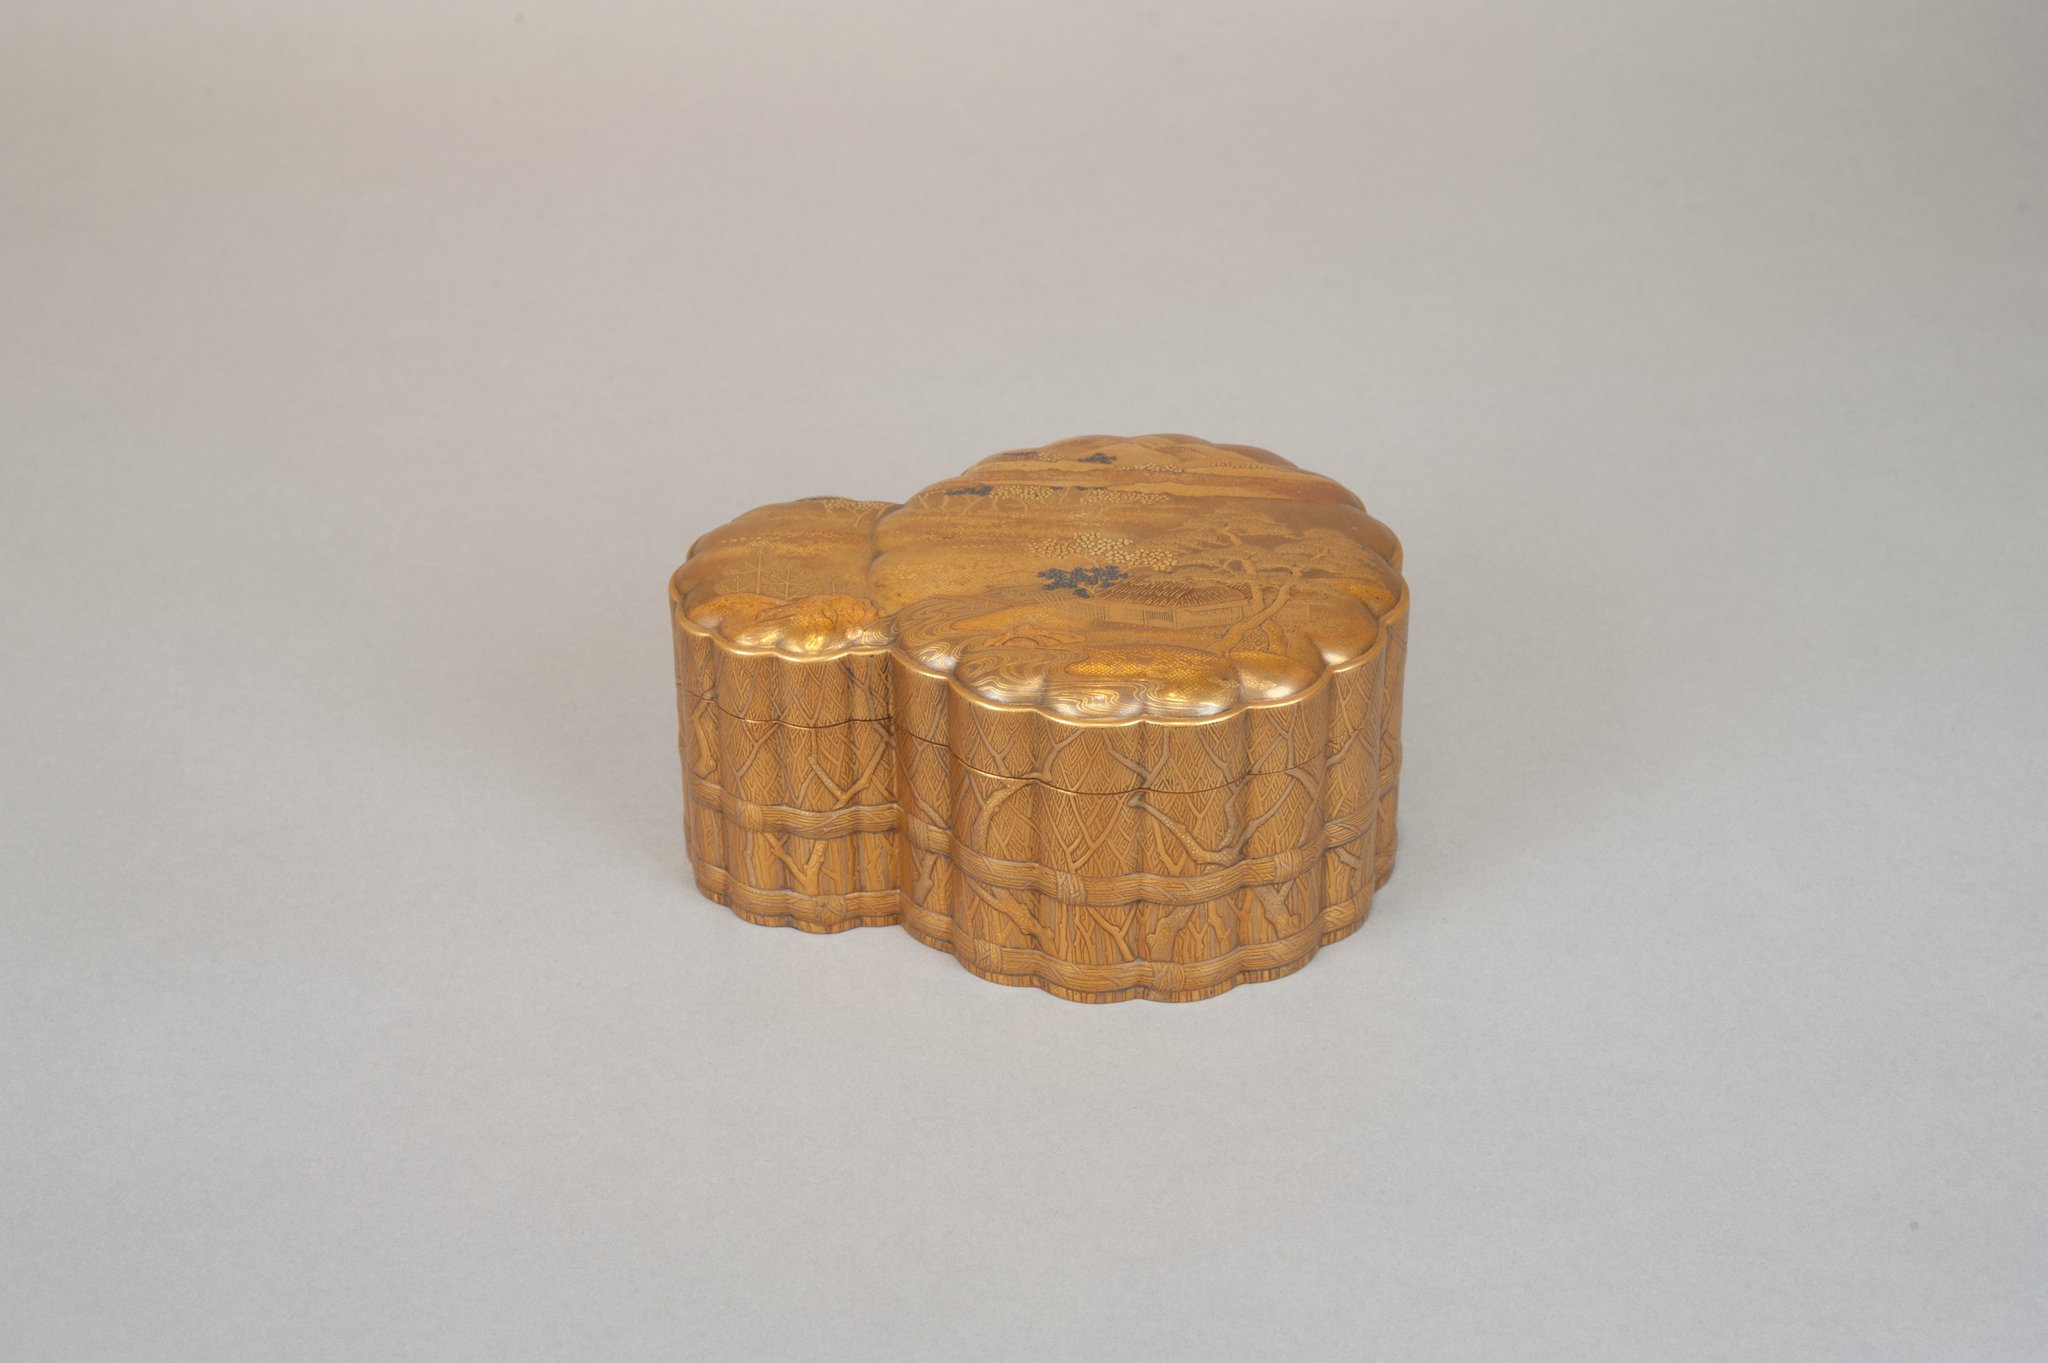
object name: incense box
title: Incense Box with Design of Landscape in Spring (Side: Fagots with Cords)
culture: japanese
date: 1601-1700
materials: gold, lacquer, silver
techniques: maki